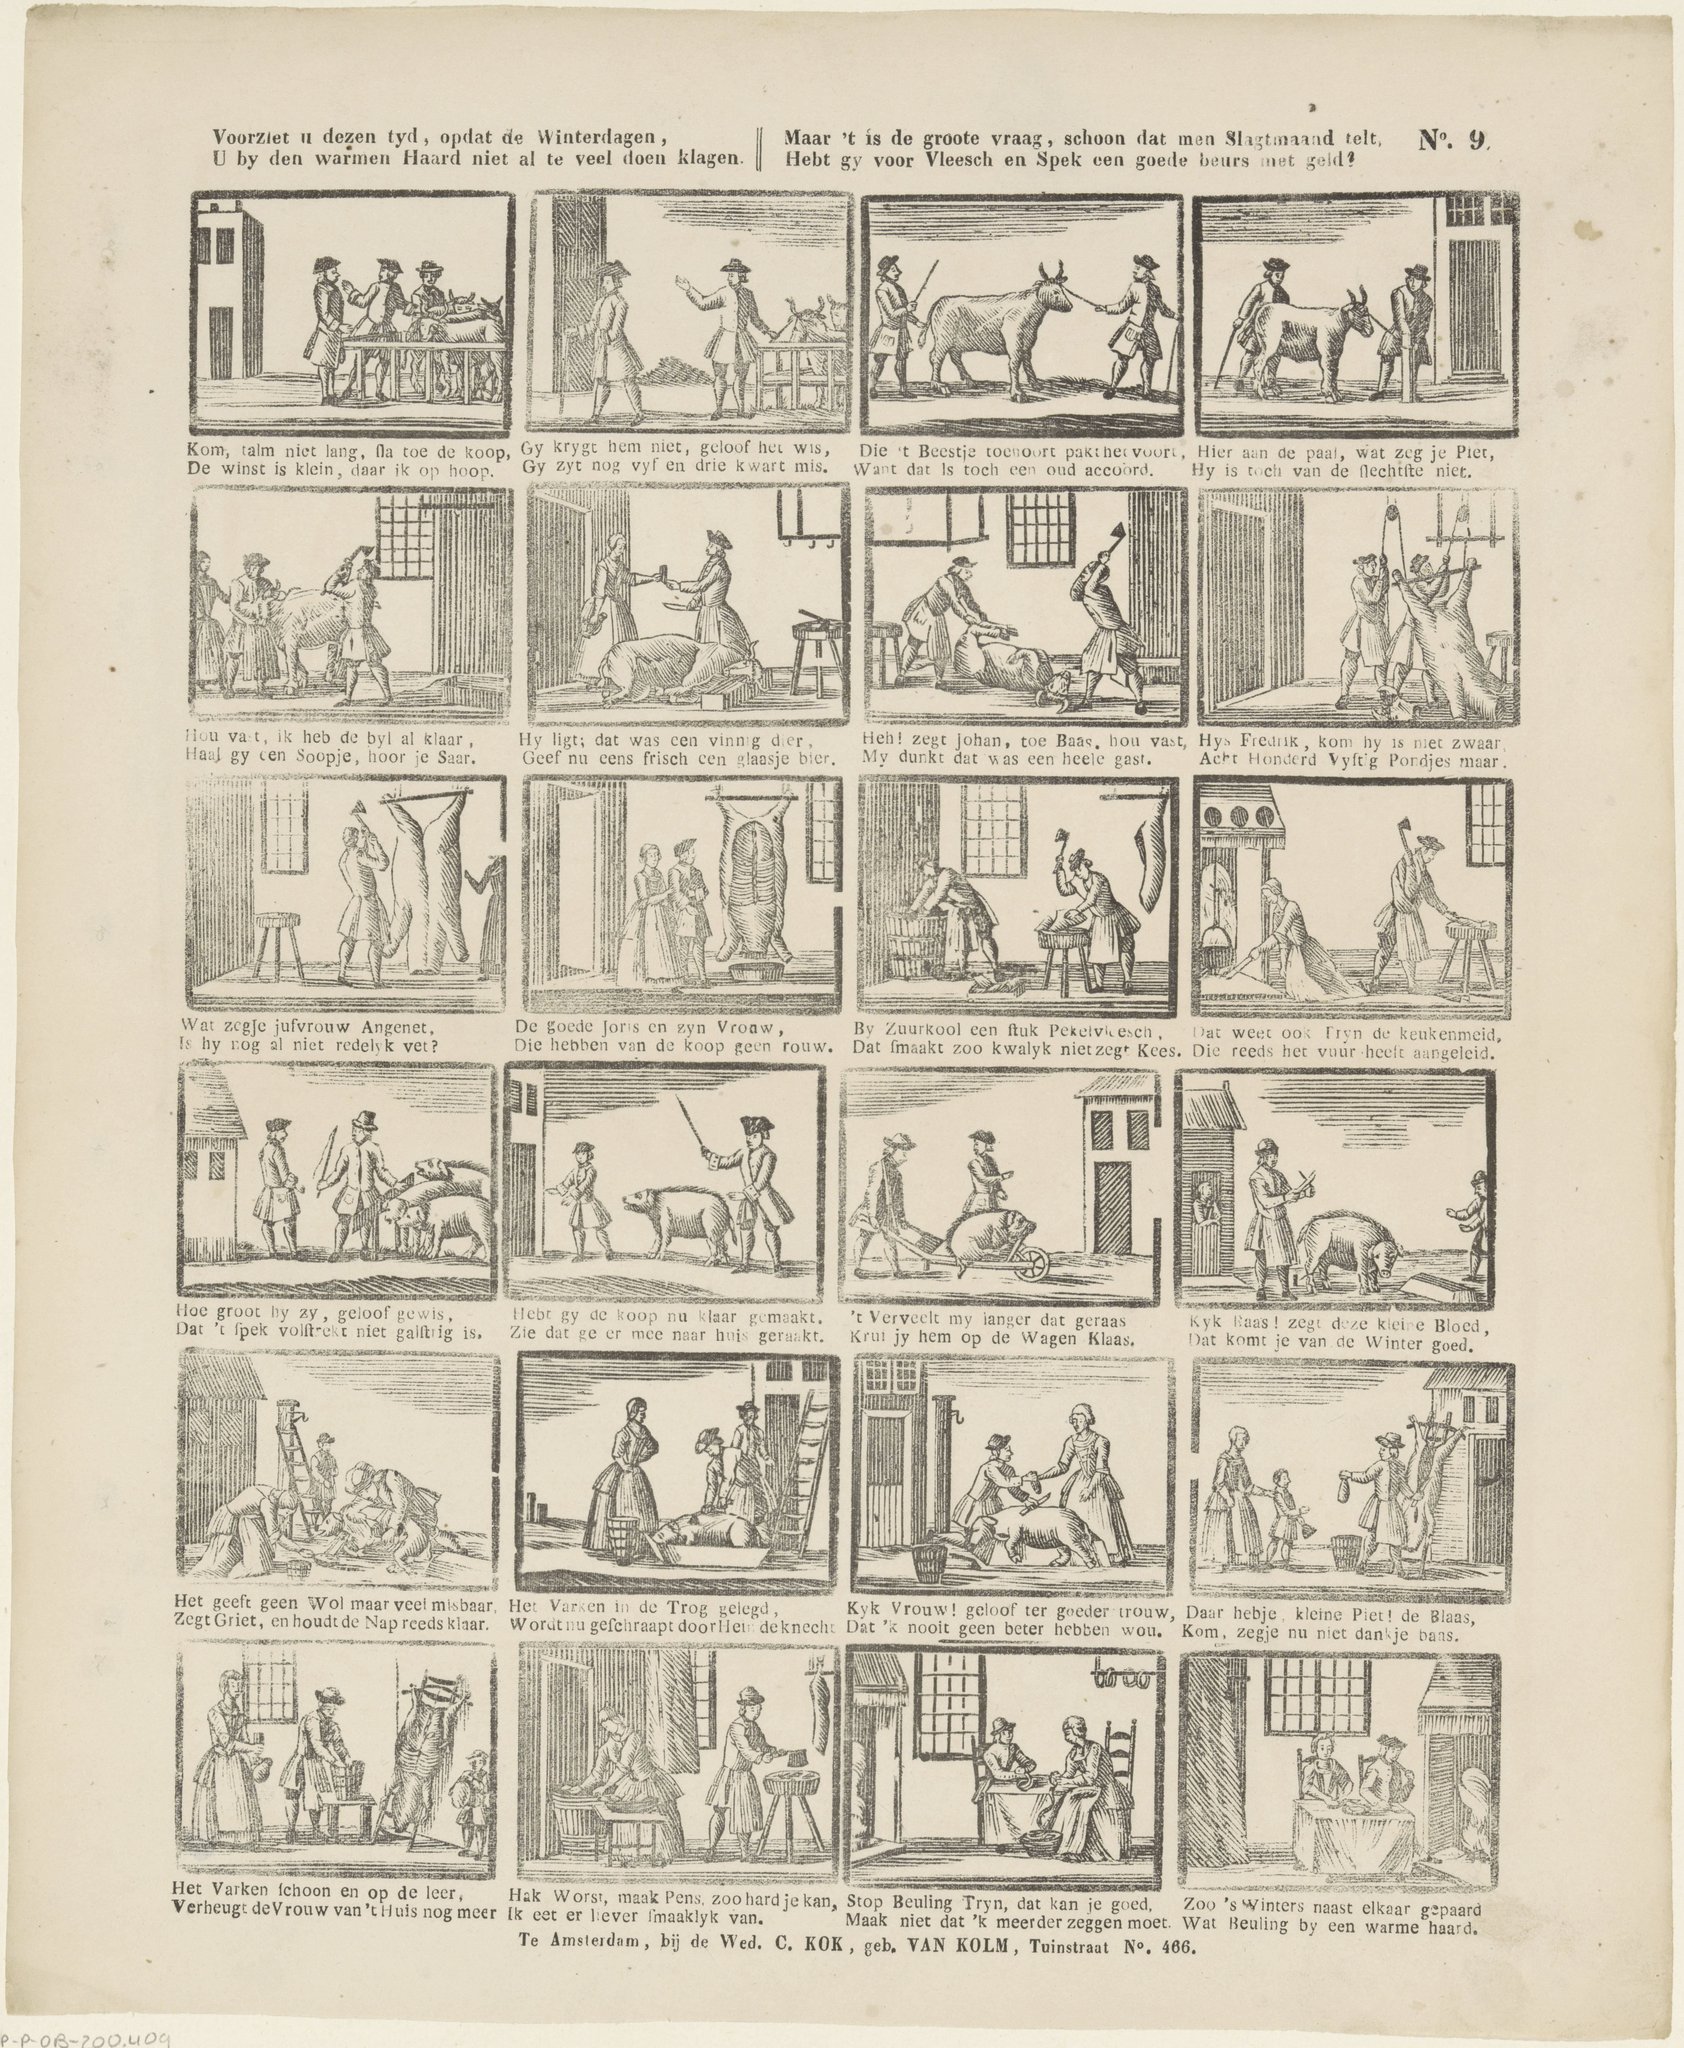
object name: print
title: Voorziet u dezen tyd, opdat de winterdagen, / U by den warmen haard niet al te veel doen klagen. / Maar 't is de groote vraag, schoon dat men slagtmaand telt, / Hebt gy voor vleesch en spek een goede beurs met geld?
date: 1842-1866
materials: paper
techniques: letterpress printing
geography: netherlands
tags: slaughtered ox or pig, butcher, slaughterman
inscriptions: collector's mark: Lugt 2760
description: Blad met 24 voorstellingen van het fokken, slachten en bereiden van koeien en varkens (de slachttijd). Onder elke afbeelding een tweeregelig vers. Genummerd rechtsboven: No 9.